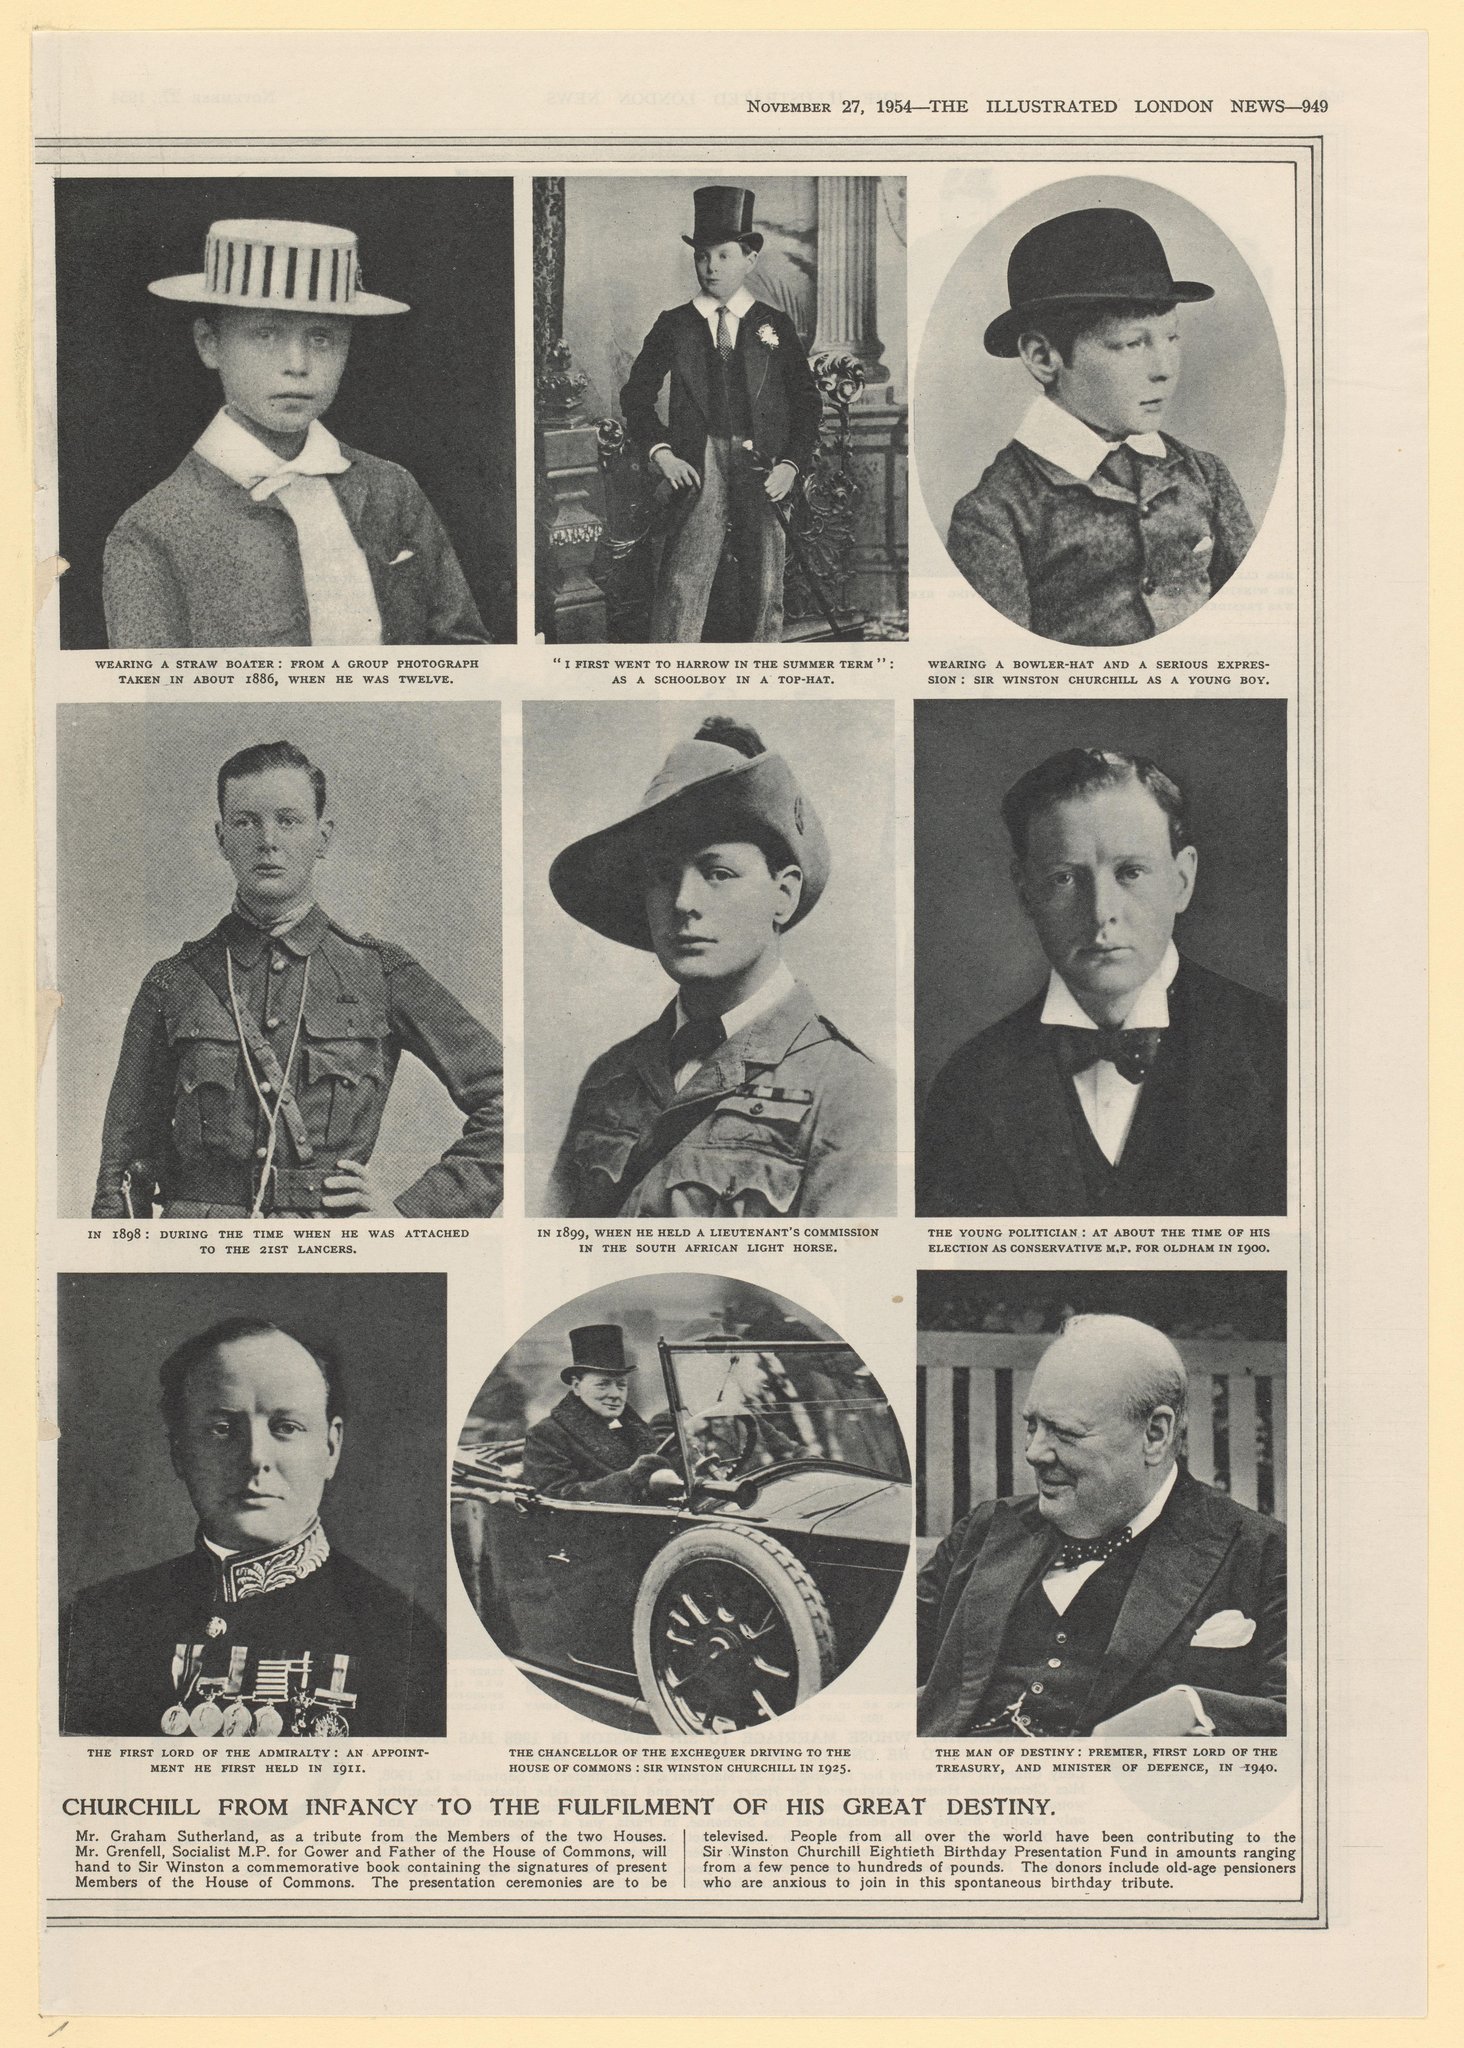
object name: photomechanical print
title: Negen portretten van Winston Churchill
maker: Anonymous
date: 1886-1954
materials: paper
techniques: rotogravure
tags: london, weekly, monthly, magazine, etc., historical persons, politician, e.g. party leader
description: Bladzijde uit 'Supplement to the Illustrated London News' van 27 november 1954 met negen portretten van Winston Churchill, van zijn jeugd tot en met zijn premierschap in de jaren 1940.